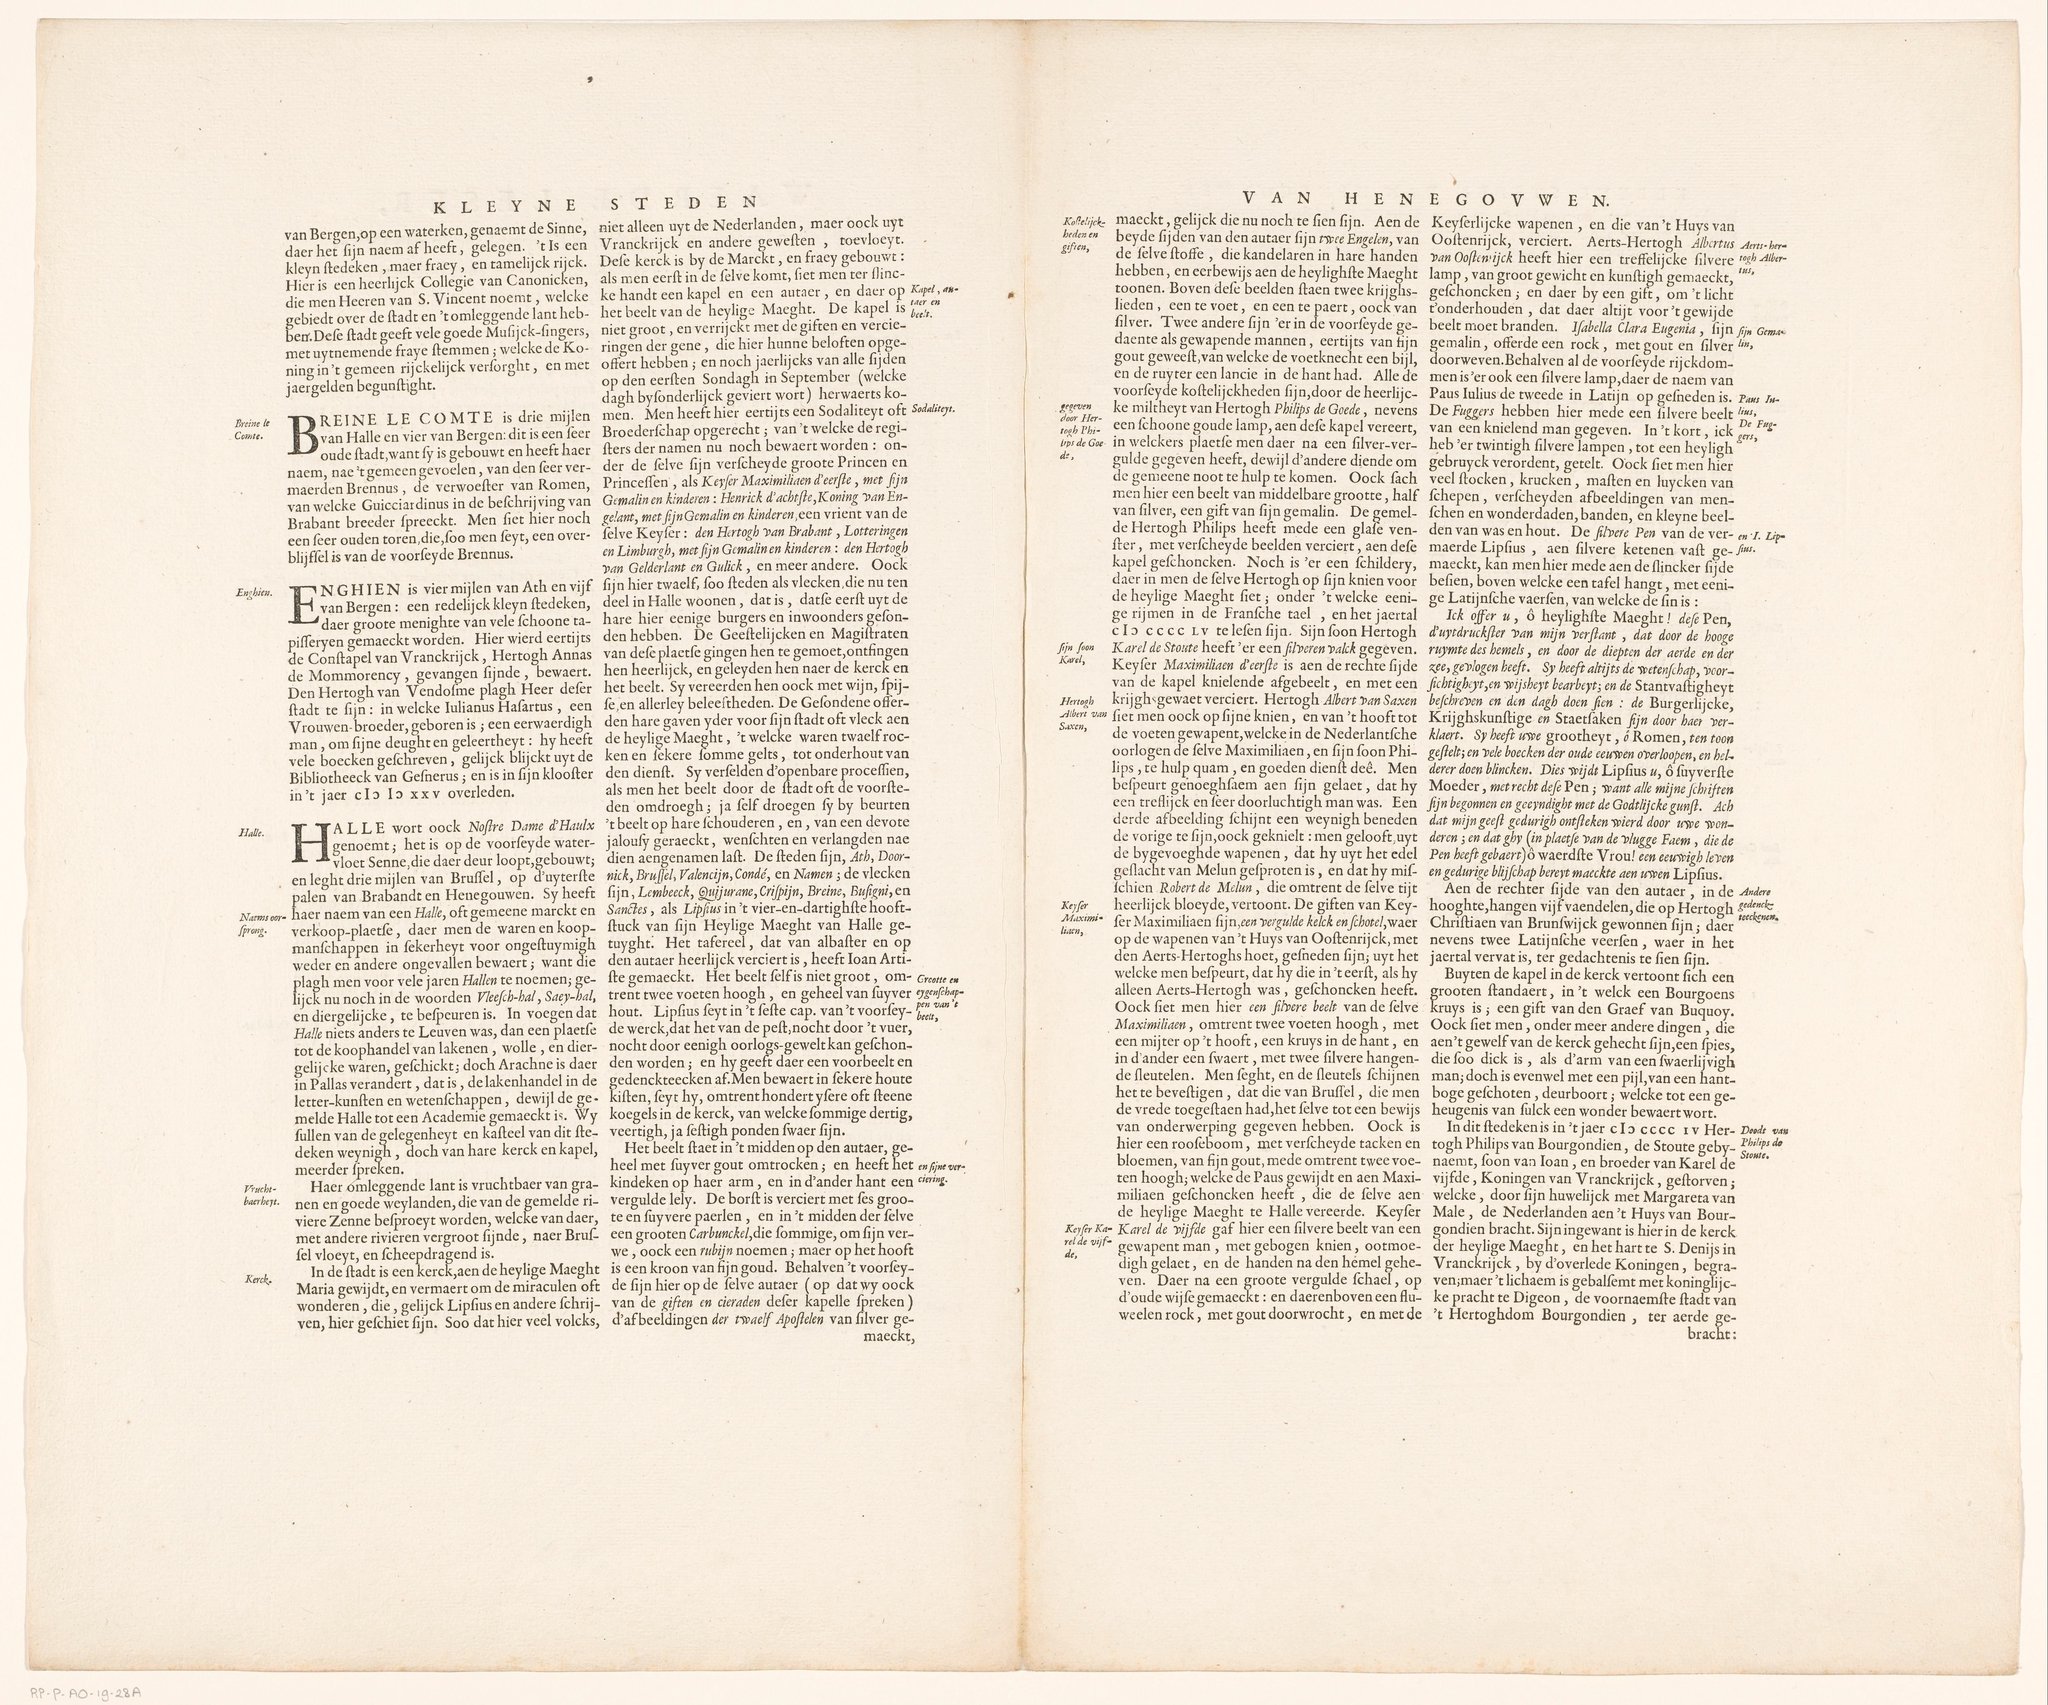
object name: text sheet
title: Deel van de beschrijving van enkele kleine steden in Henegouwen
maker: johannes willemszoon blaeu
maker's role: printer, publisher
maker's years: 1596-1673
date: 1652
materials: paper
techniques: letterpress printing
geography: amsterdam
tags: henegouwen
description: Tekst gebruikt in: Blaeu, Johannes Willemszoon. Toonneel der steden van de Vereenighde Nederlanden. 2 delen. Amsterdam: Johannes Willemszoon Blaeu, 1652, dl. 2.